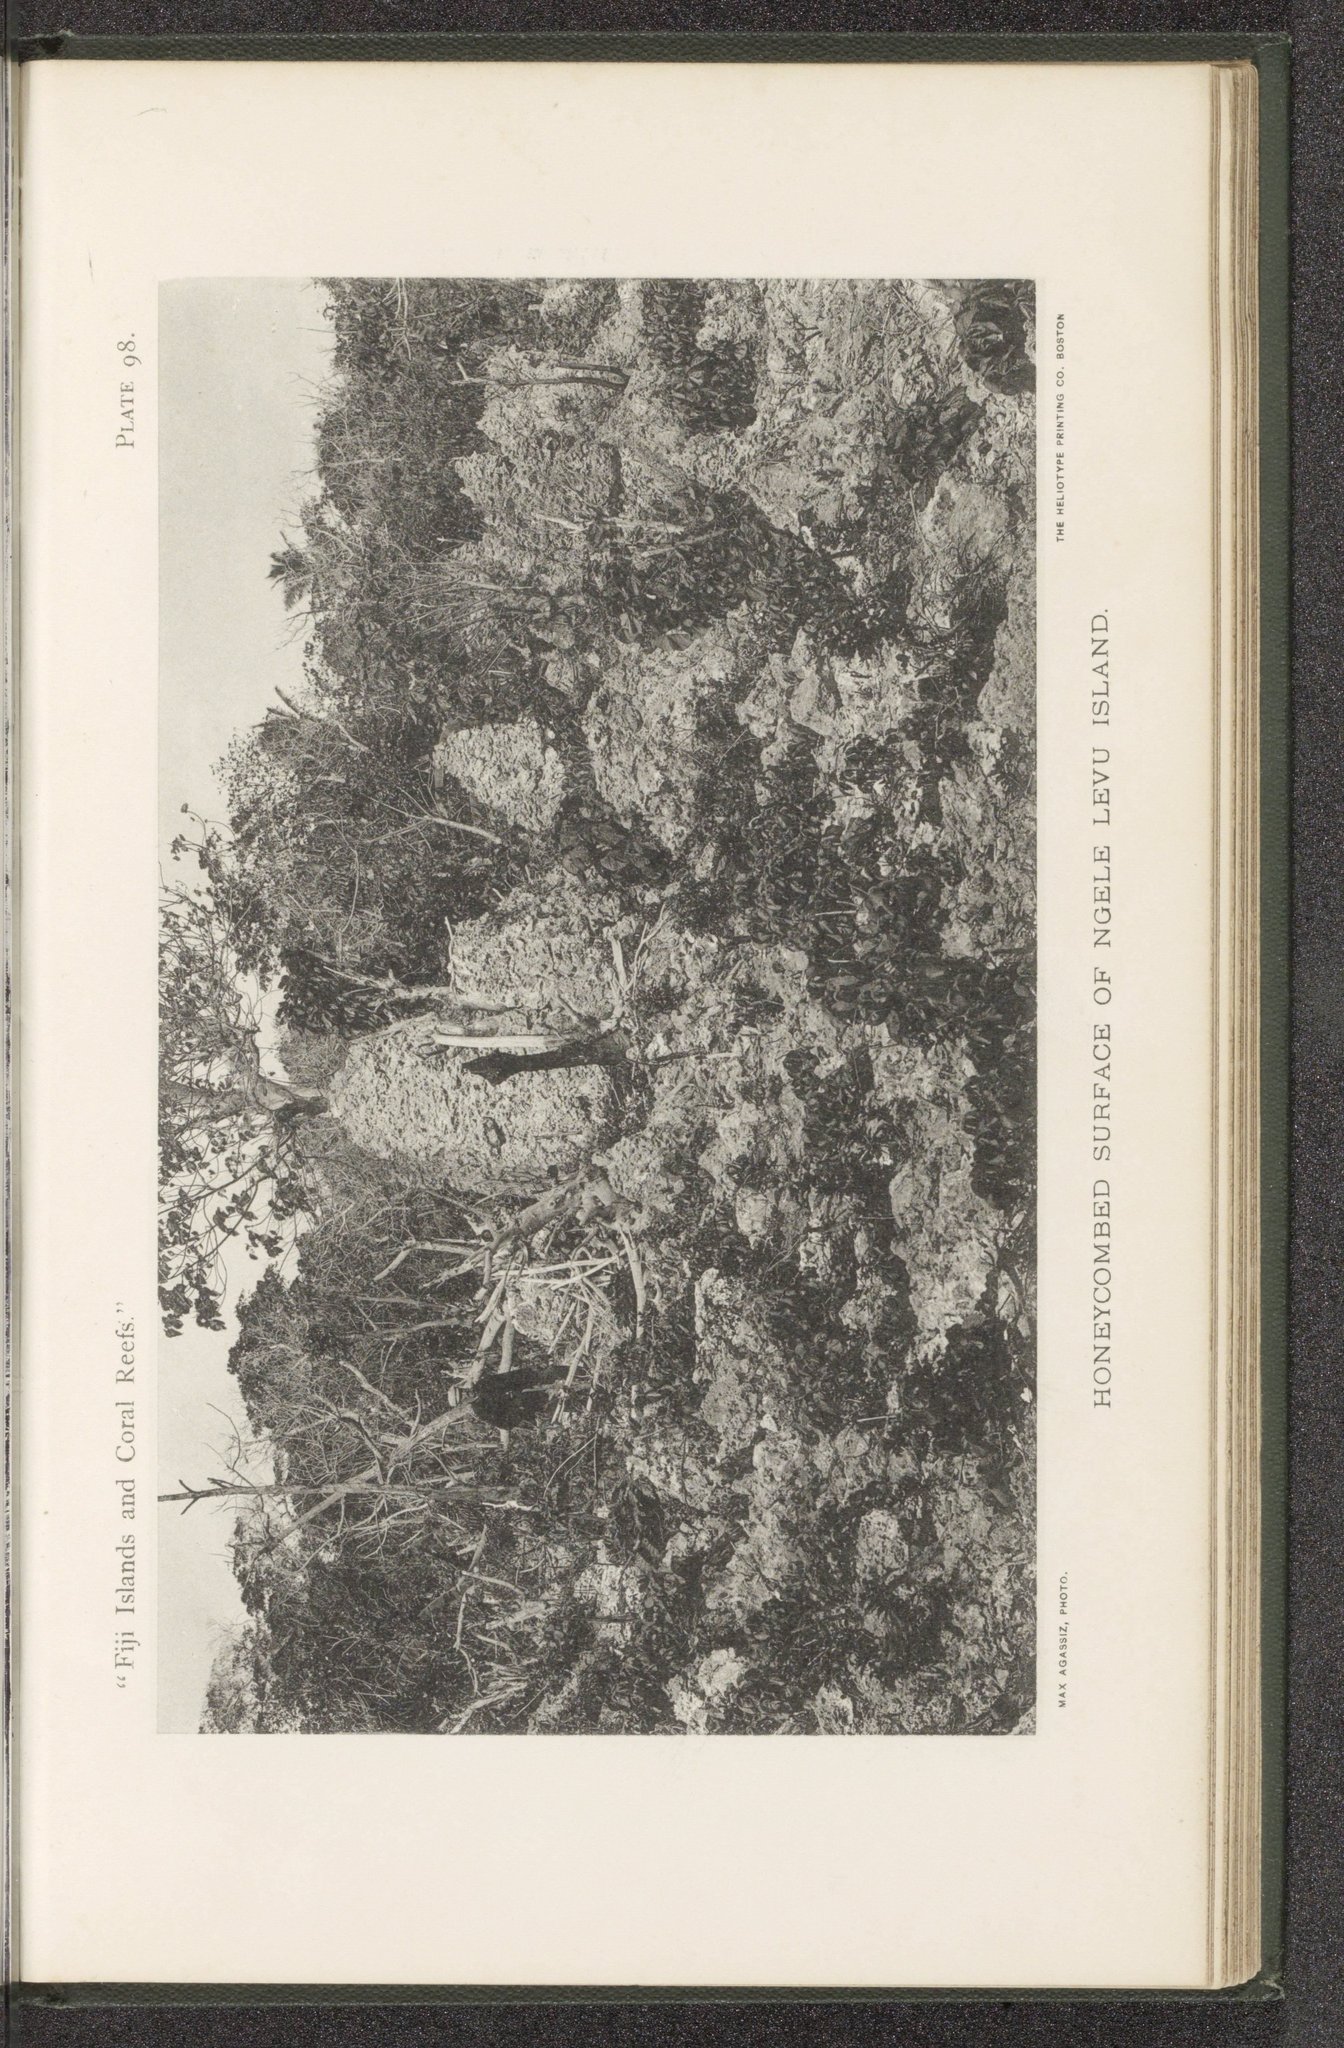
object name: page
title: Gezicht op rotsen met honingraatmotief met en man ernaast op Ngele Levu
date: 1885-1899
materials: paper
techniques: photograph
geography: fiji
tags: island, honey-comb, rocks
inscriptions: name: ‘Max Agassiz, Photo.’, name: ‘The Heliotype Printing Co. Boston’, number: ‘Plate 98.’